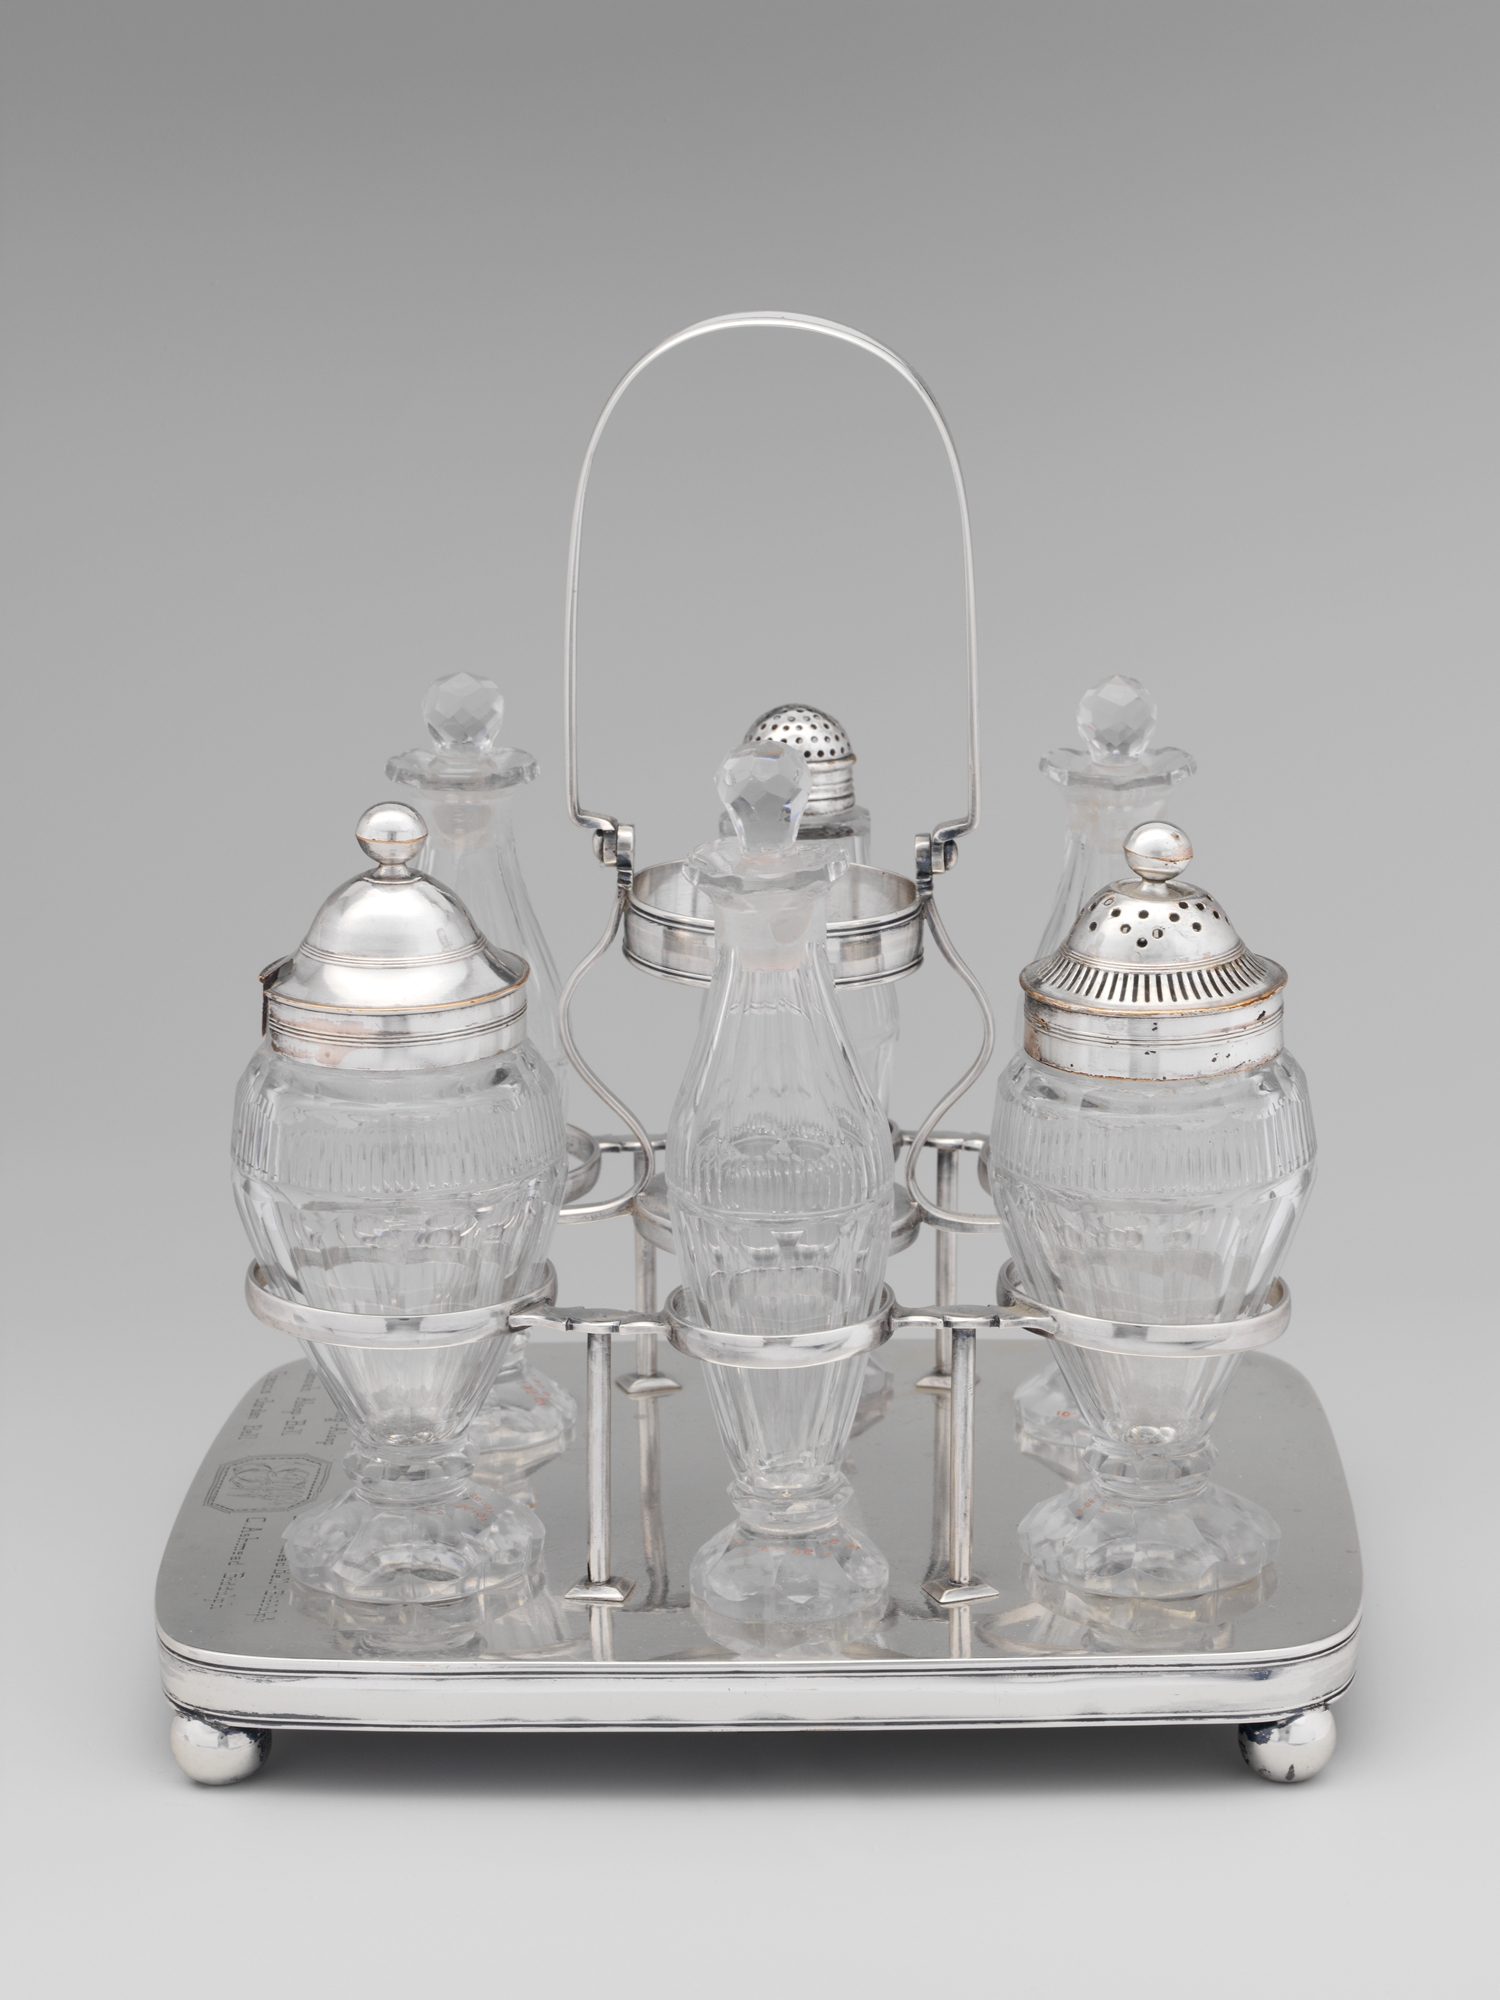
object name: cruet stand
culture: american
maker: lewis and smith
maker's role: maker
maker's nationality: american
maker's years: 1802-1811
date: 1805-1811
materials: silver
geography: united states